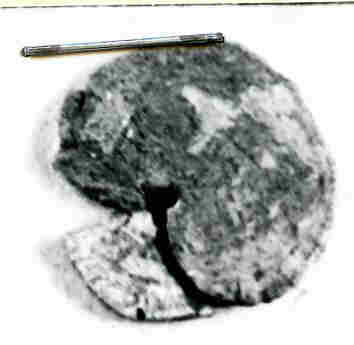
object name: coin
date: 701-900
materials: copper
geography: iran